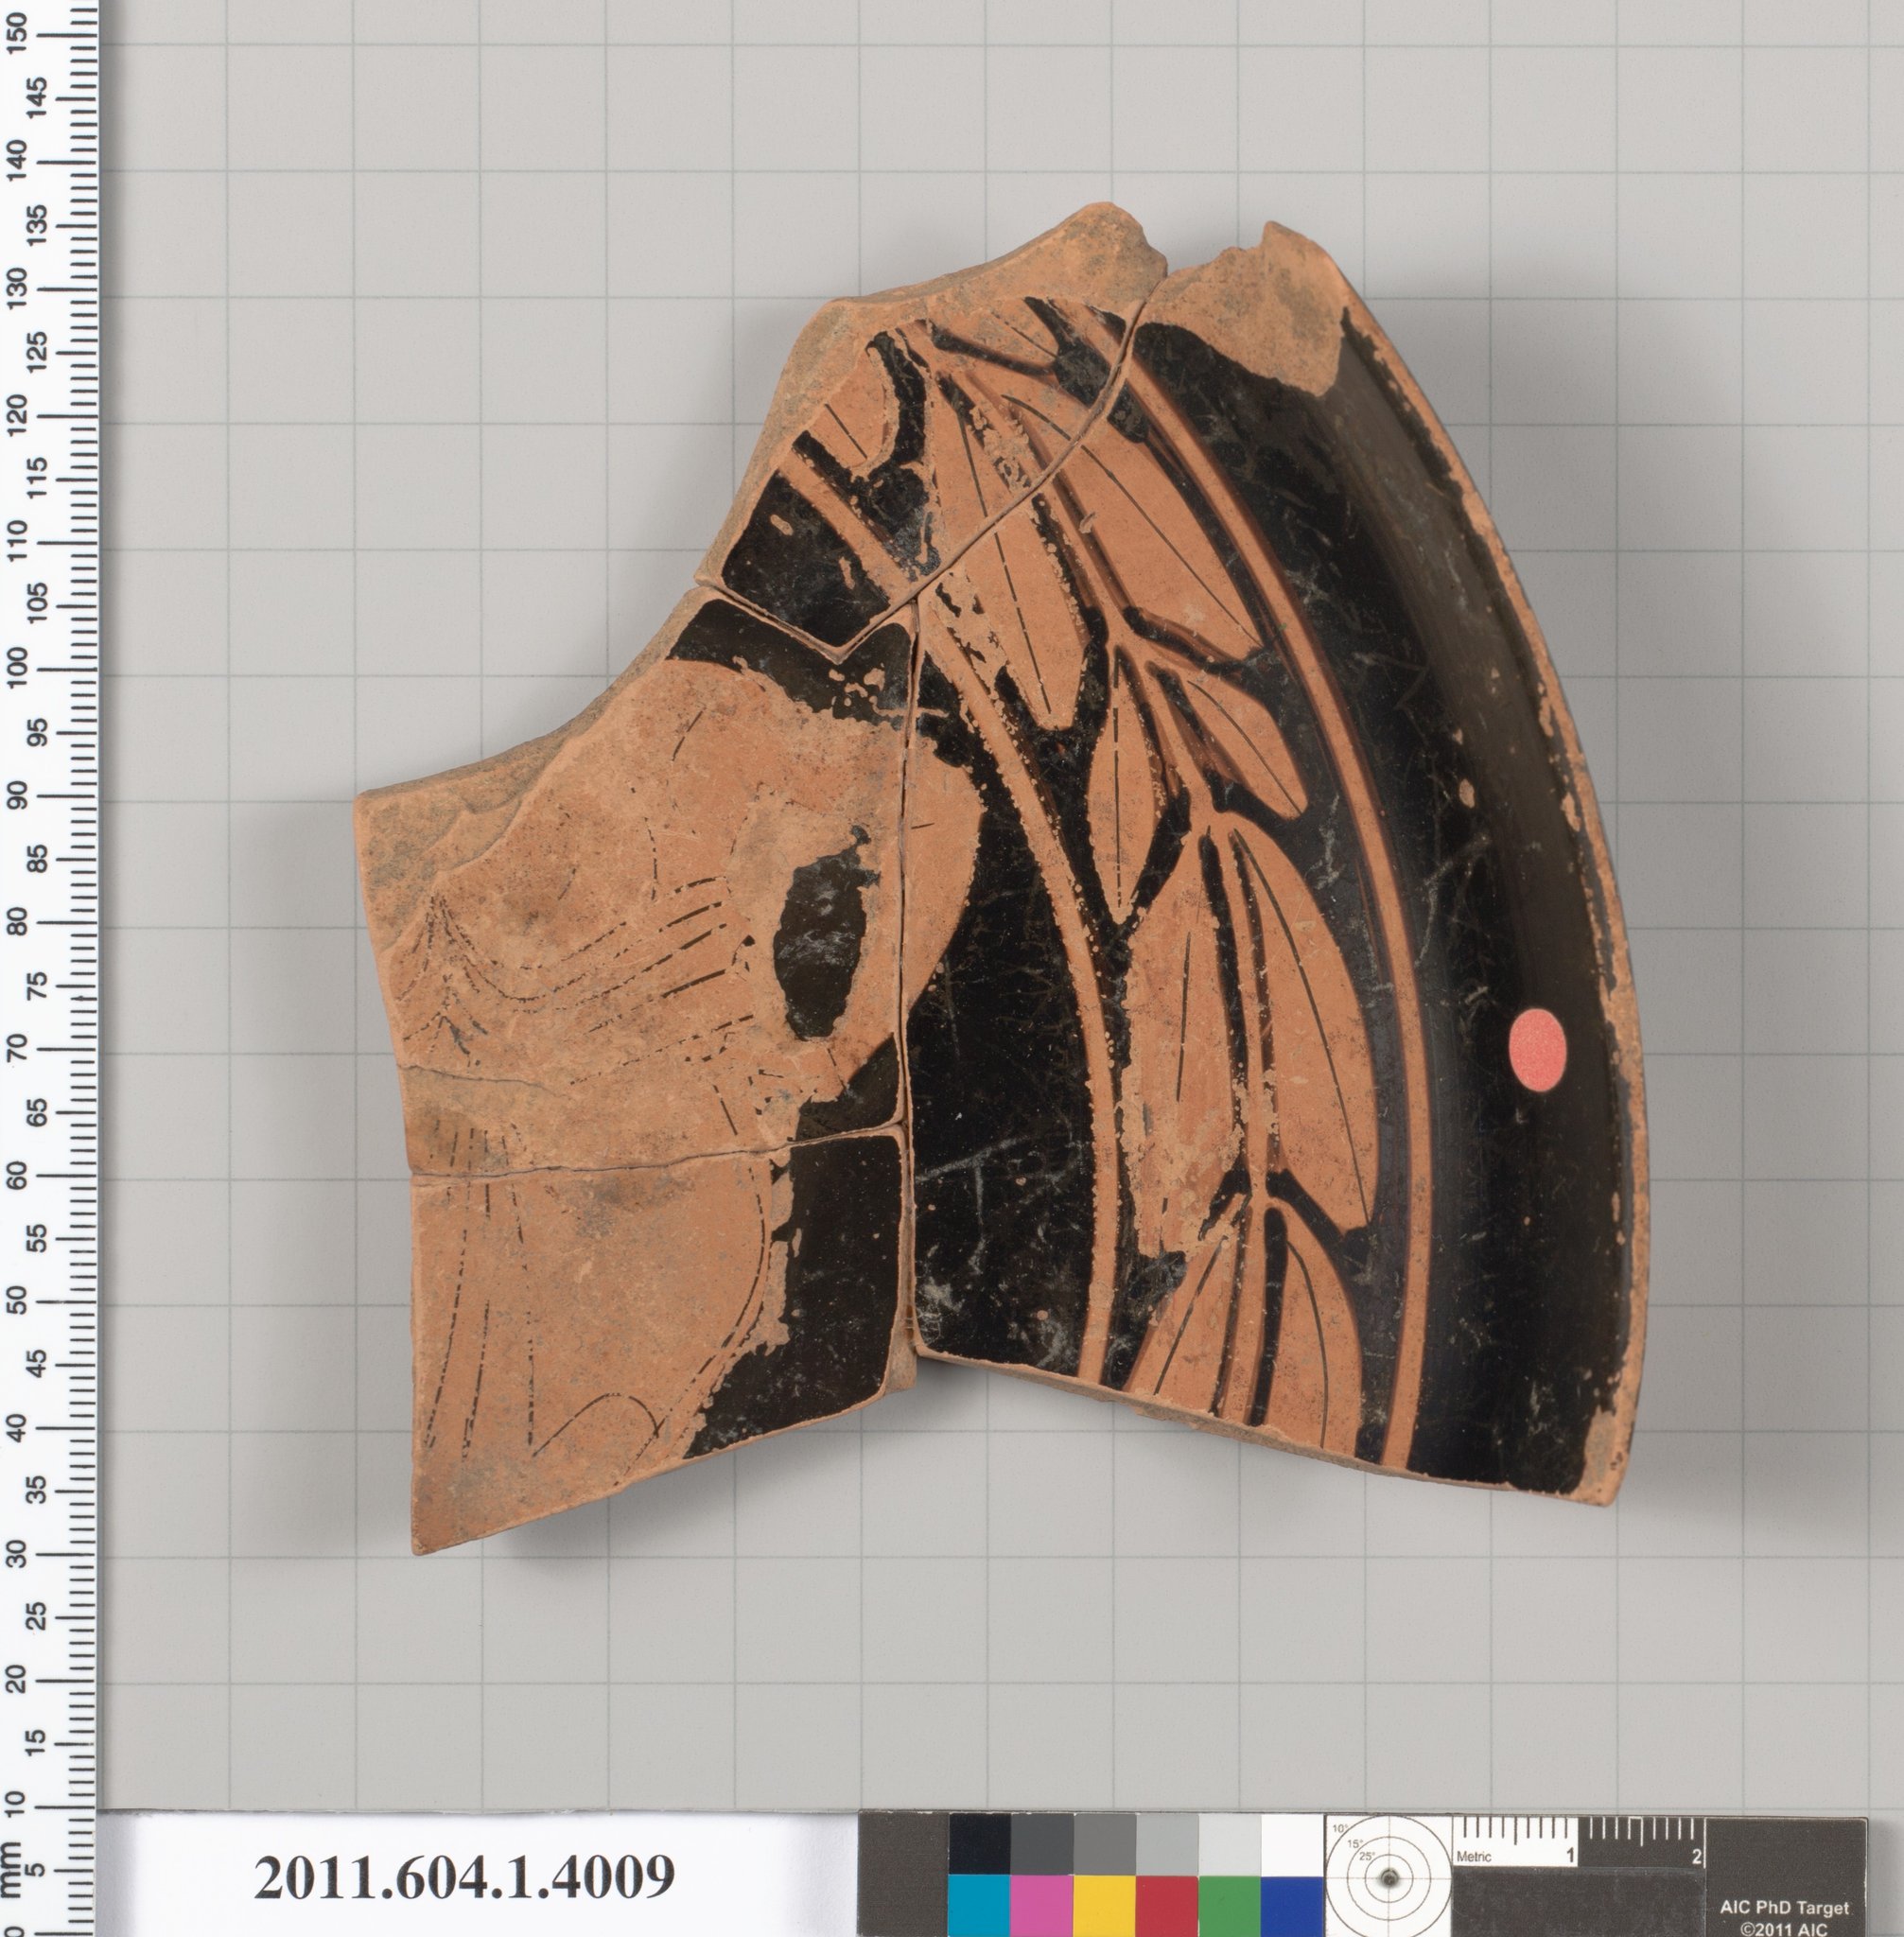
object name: kylix fragment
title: Terracotta fragment of a kylix (drinking cup)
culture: greek, attic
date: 460-440 BCE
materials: terracotta